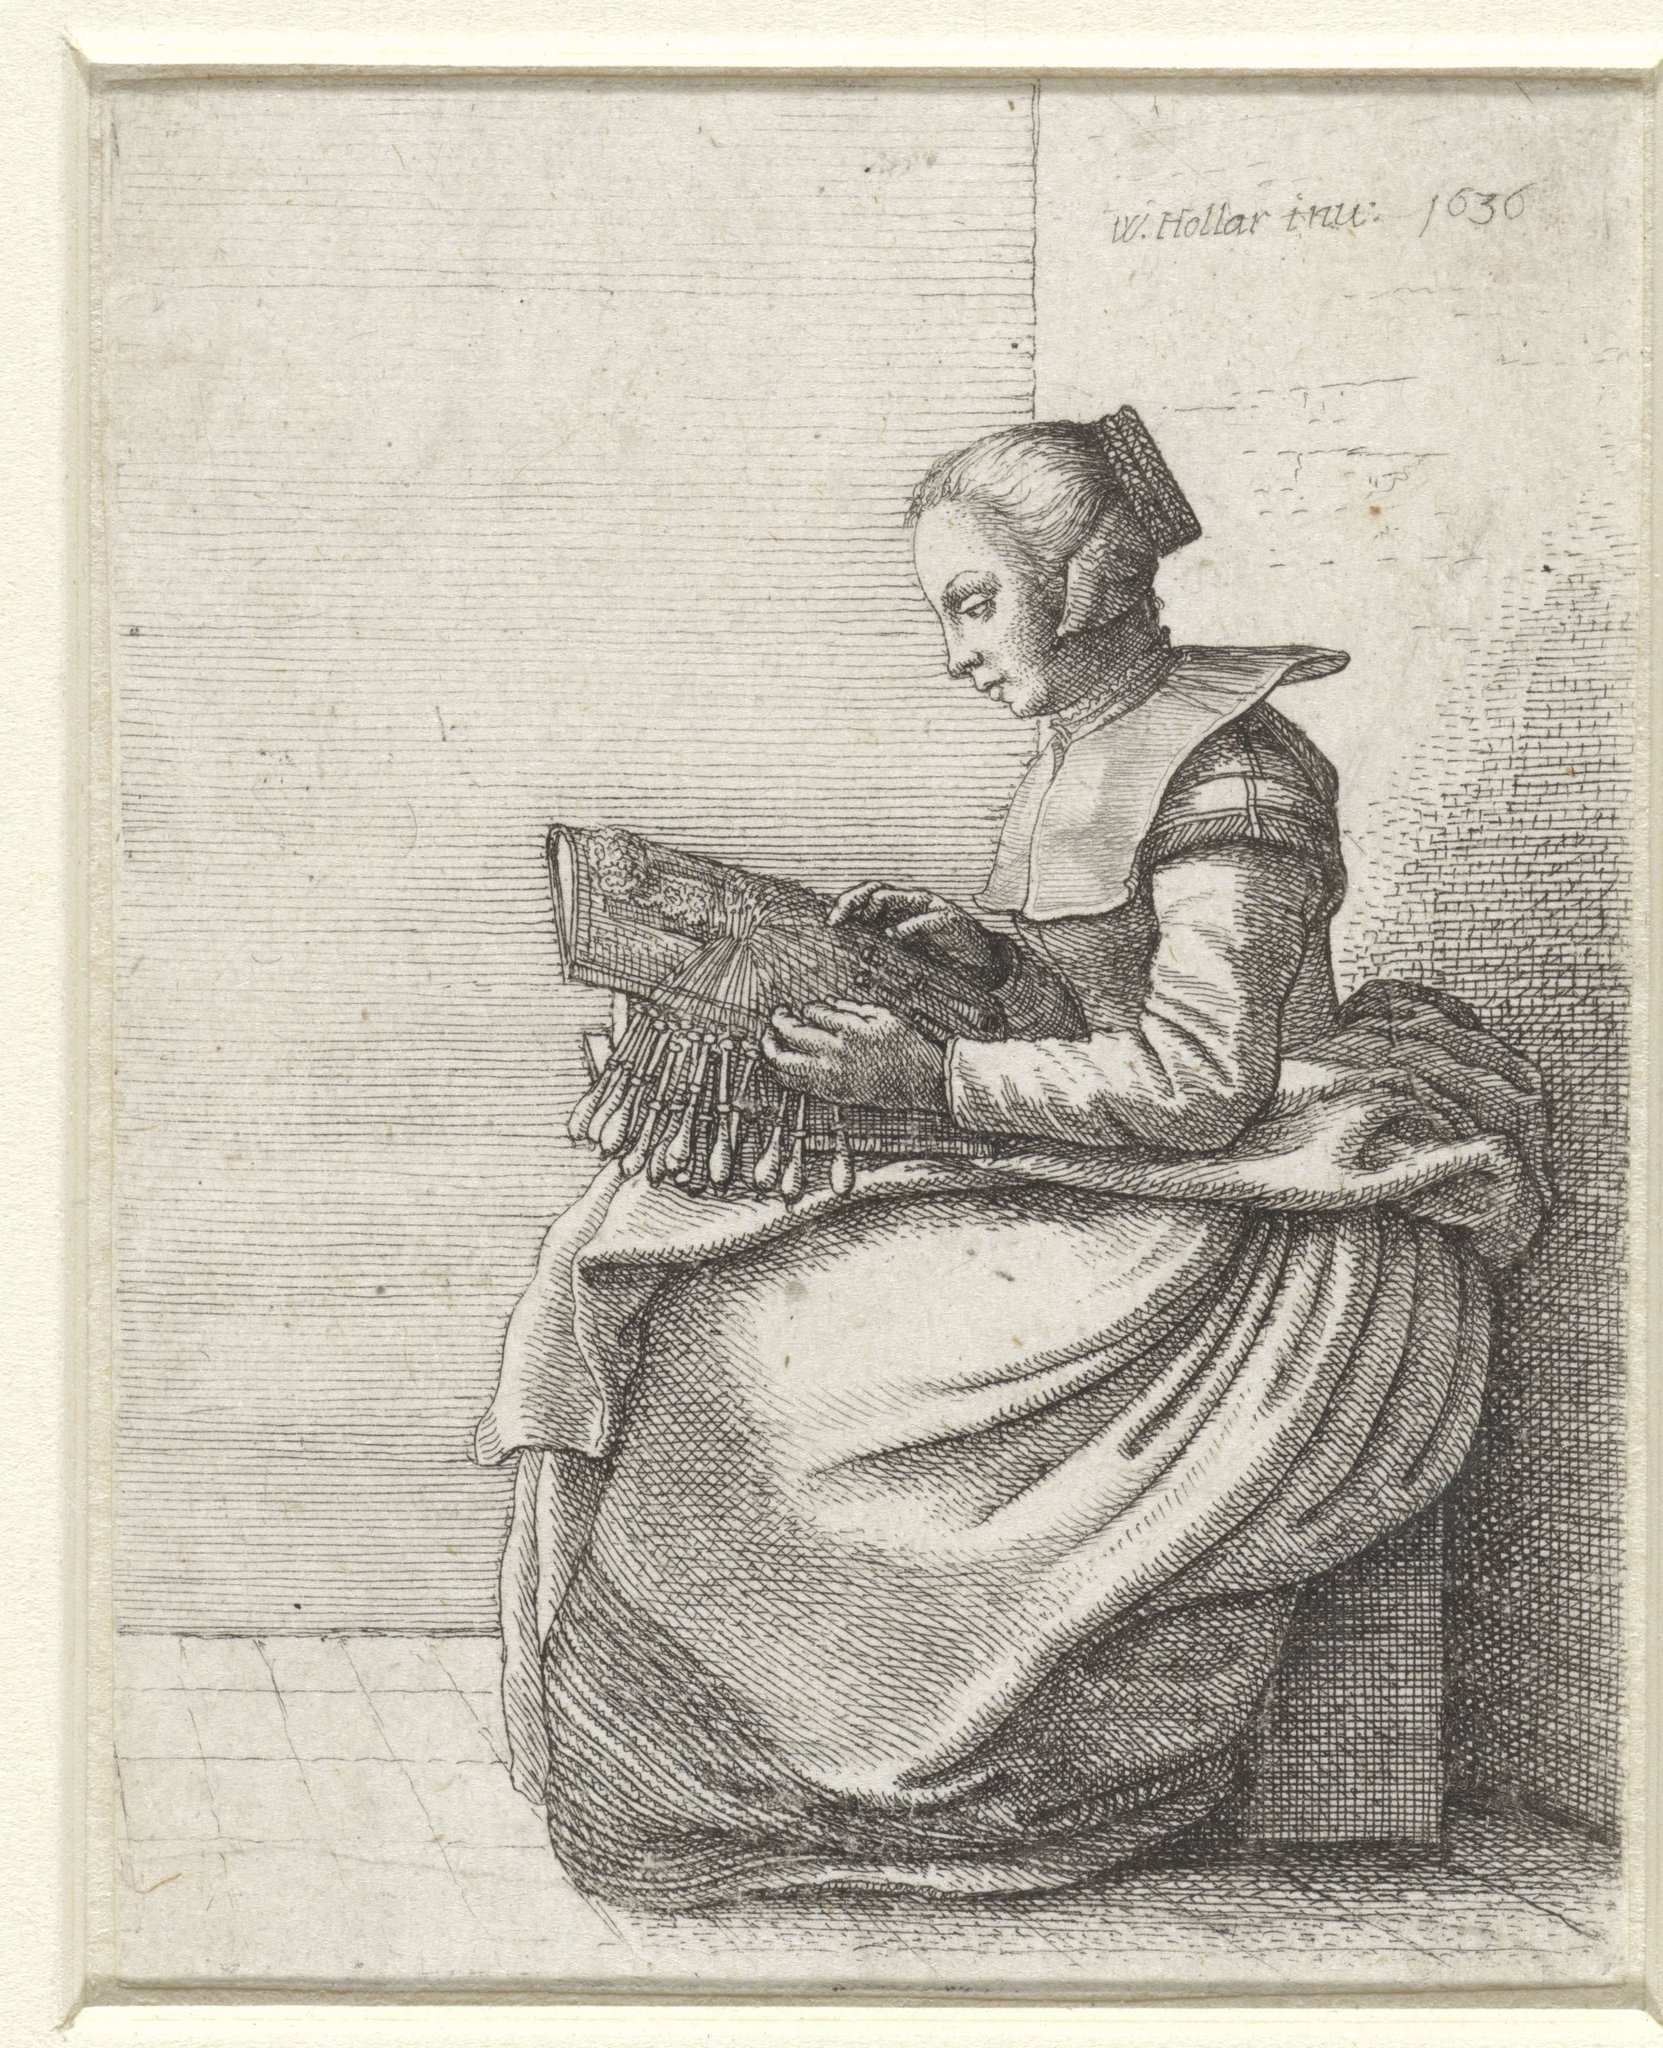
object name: print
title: Kantwerkster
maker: wenceslaus hollar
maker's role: draughtsman, print maker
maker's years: 1607-1677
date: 1636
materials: paper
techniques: etching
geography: germany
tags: lace-making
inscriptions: collector's mark: Lugt 654